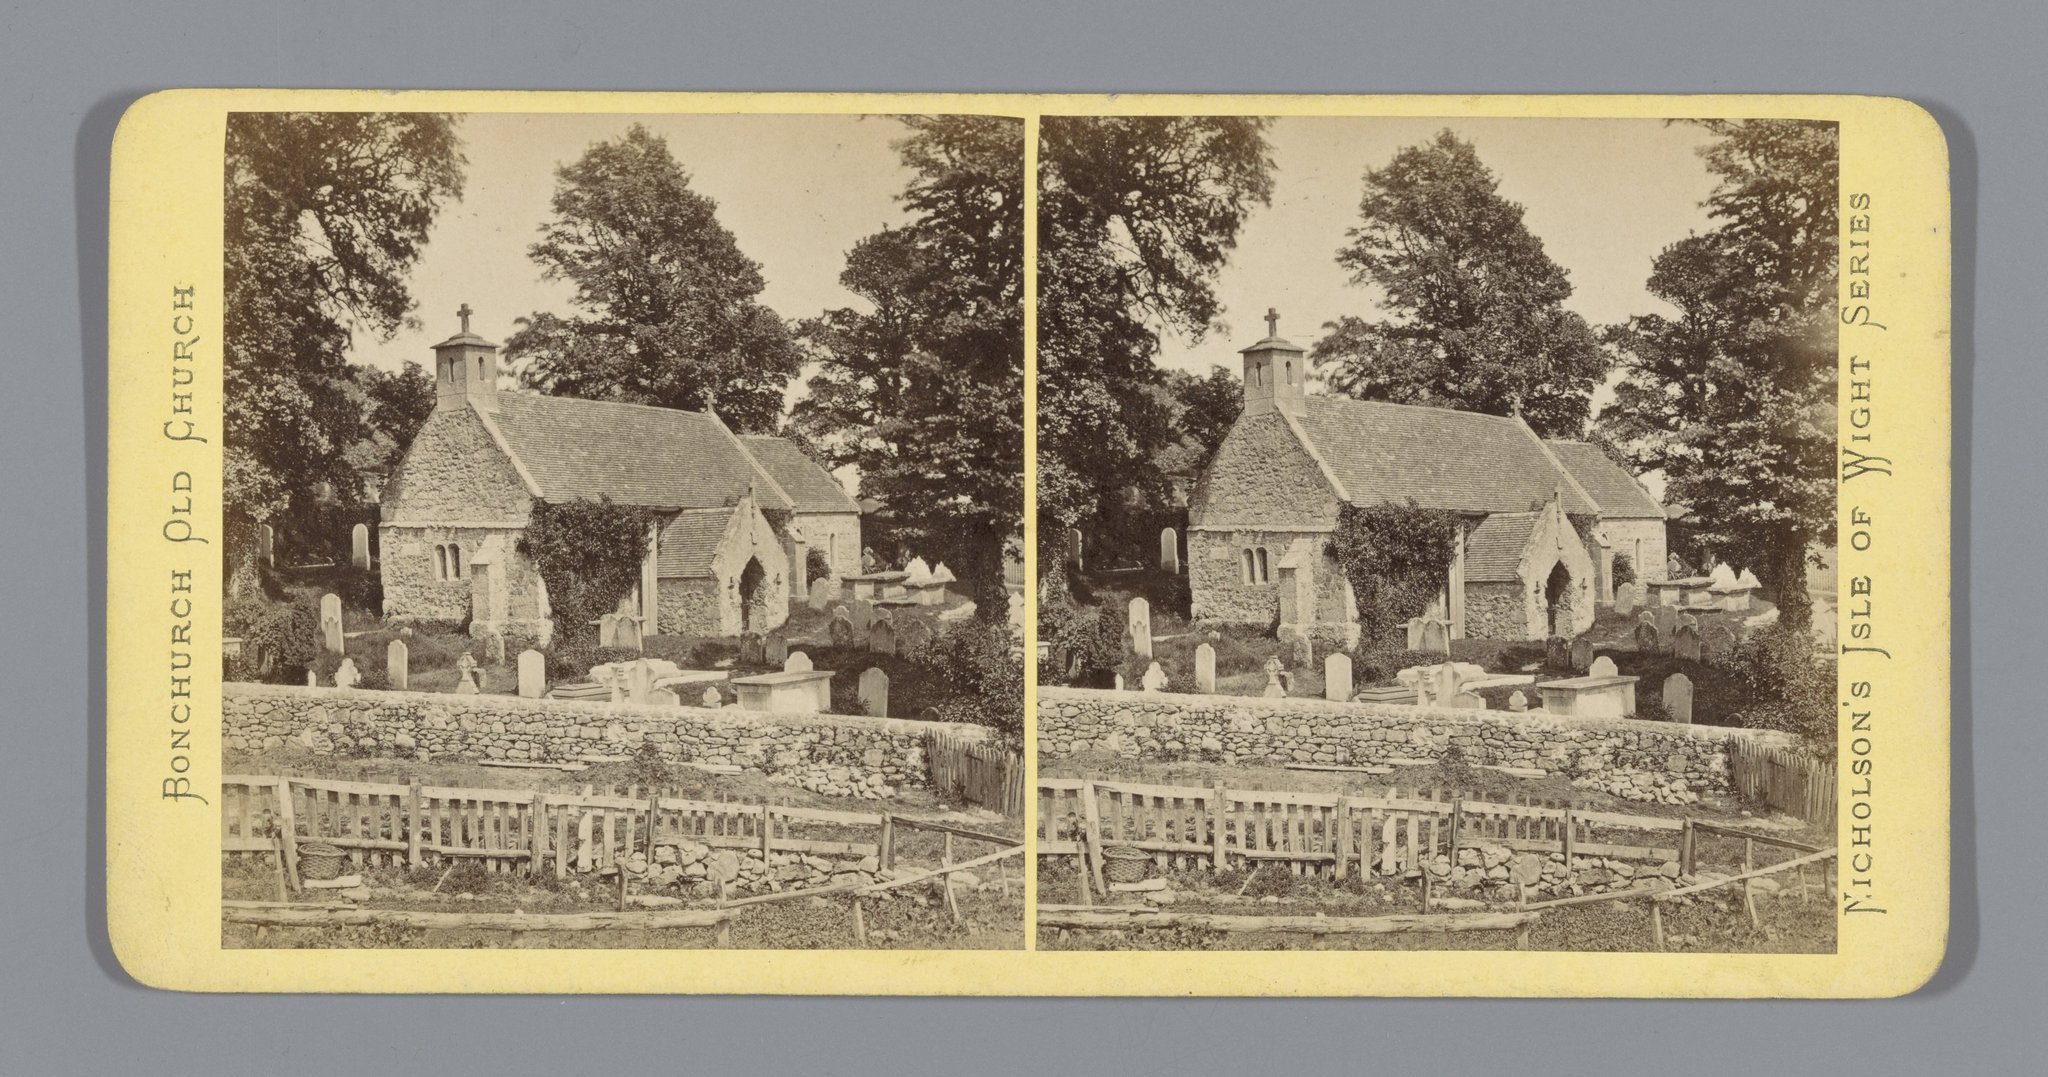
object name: stereograph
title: Gezicht op de Bonifatiuskerk te Bonchurch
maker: j.w. nicholson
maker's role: fotograaf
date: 1850-1880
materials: cardboard, photographic support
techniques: albumen print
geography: bonchurch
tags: church (exterior), churchyard (around church)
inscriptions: inscription: ‘Nicholson's Isle of Wight Series’